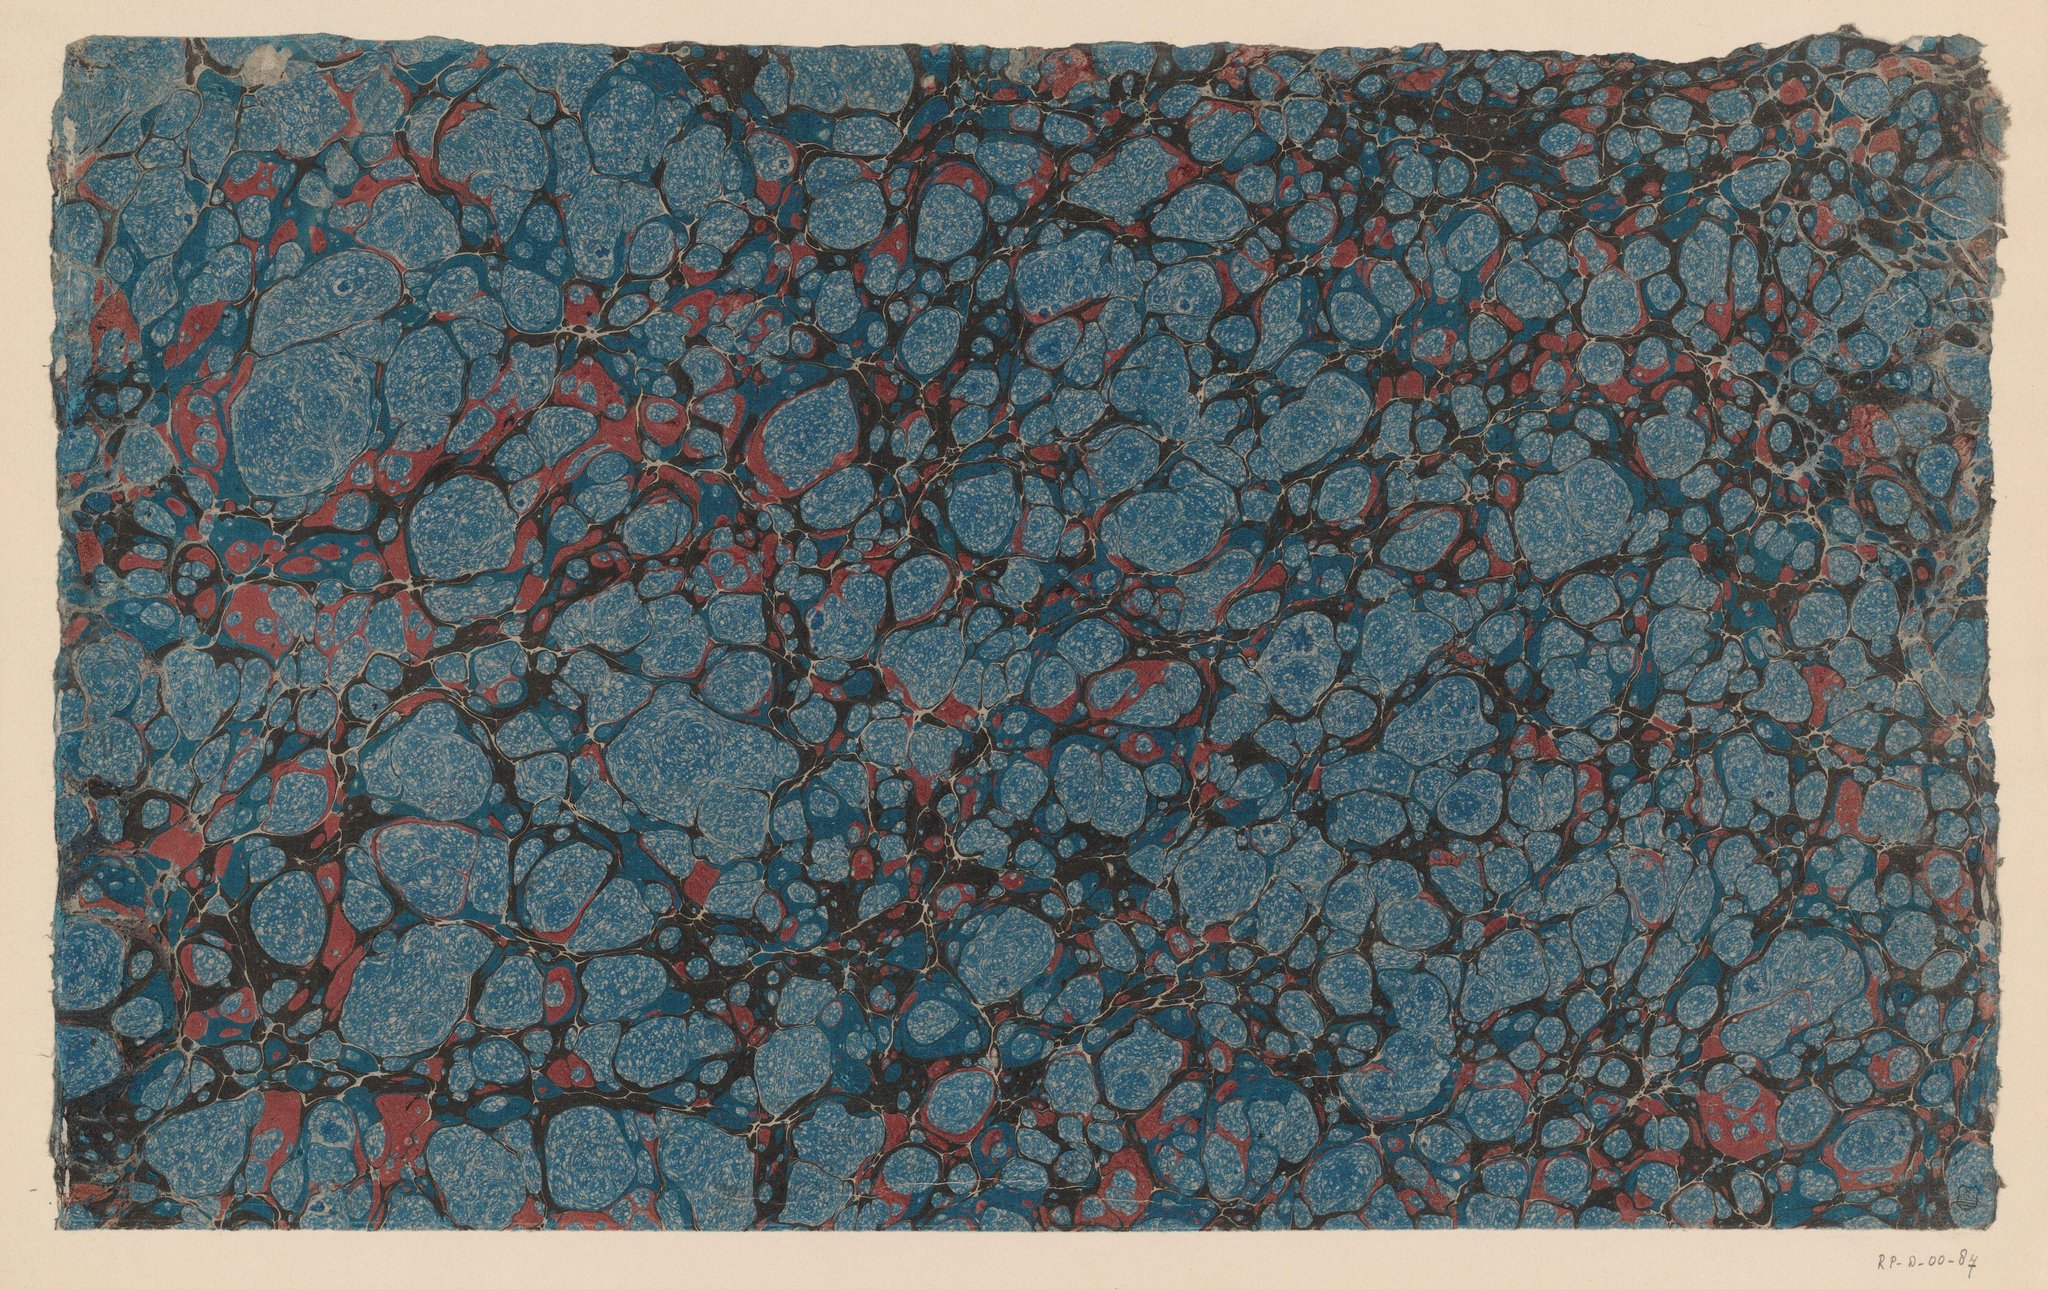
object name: marbled paper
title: Graniet-kiezelmarmer in blauw, rood en zwart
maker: Anonymous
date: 1700-1850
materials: paint, paper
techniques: marbling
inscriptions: collector's mark: Lugt 2760